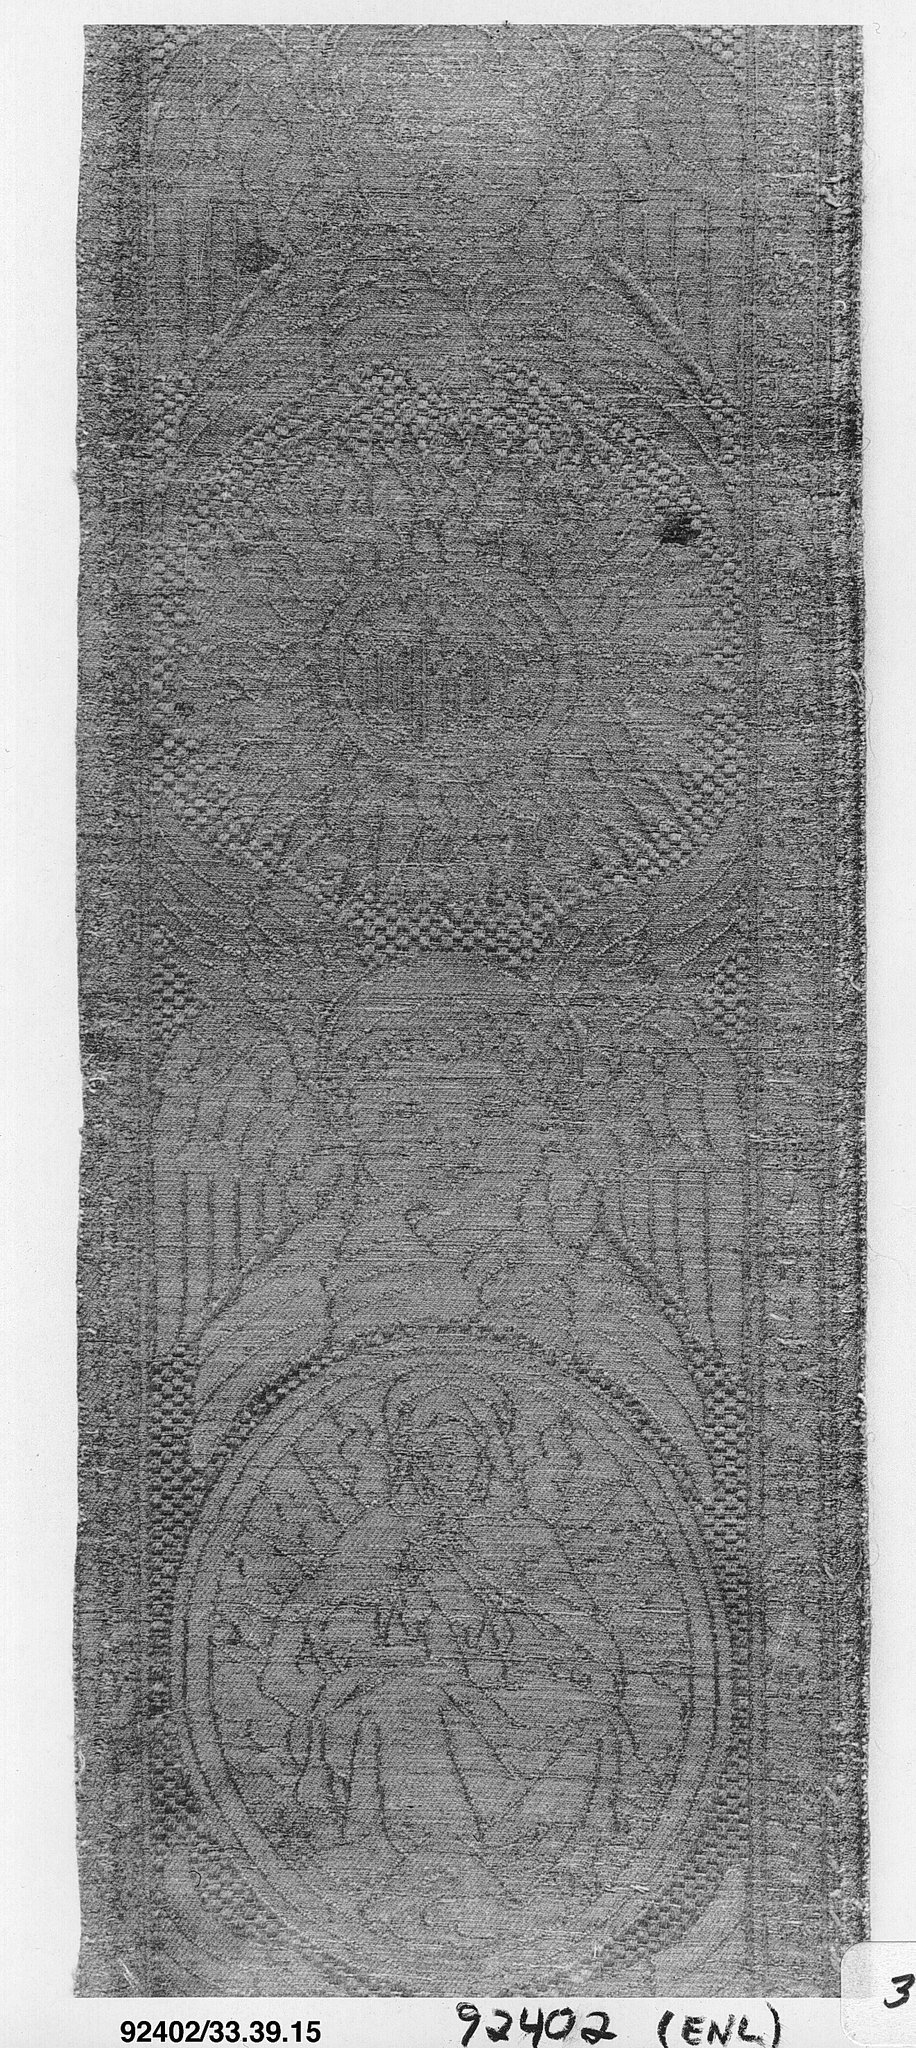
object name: orphrey fragment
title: Orphrey woven with figurative design of Seraphim with IHS Christogram in glory, and God the Father holding the Dead Christ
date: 1401-1600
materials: linen, metal thread, silk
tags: virgin mary